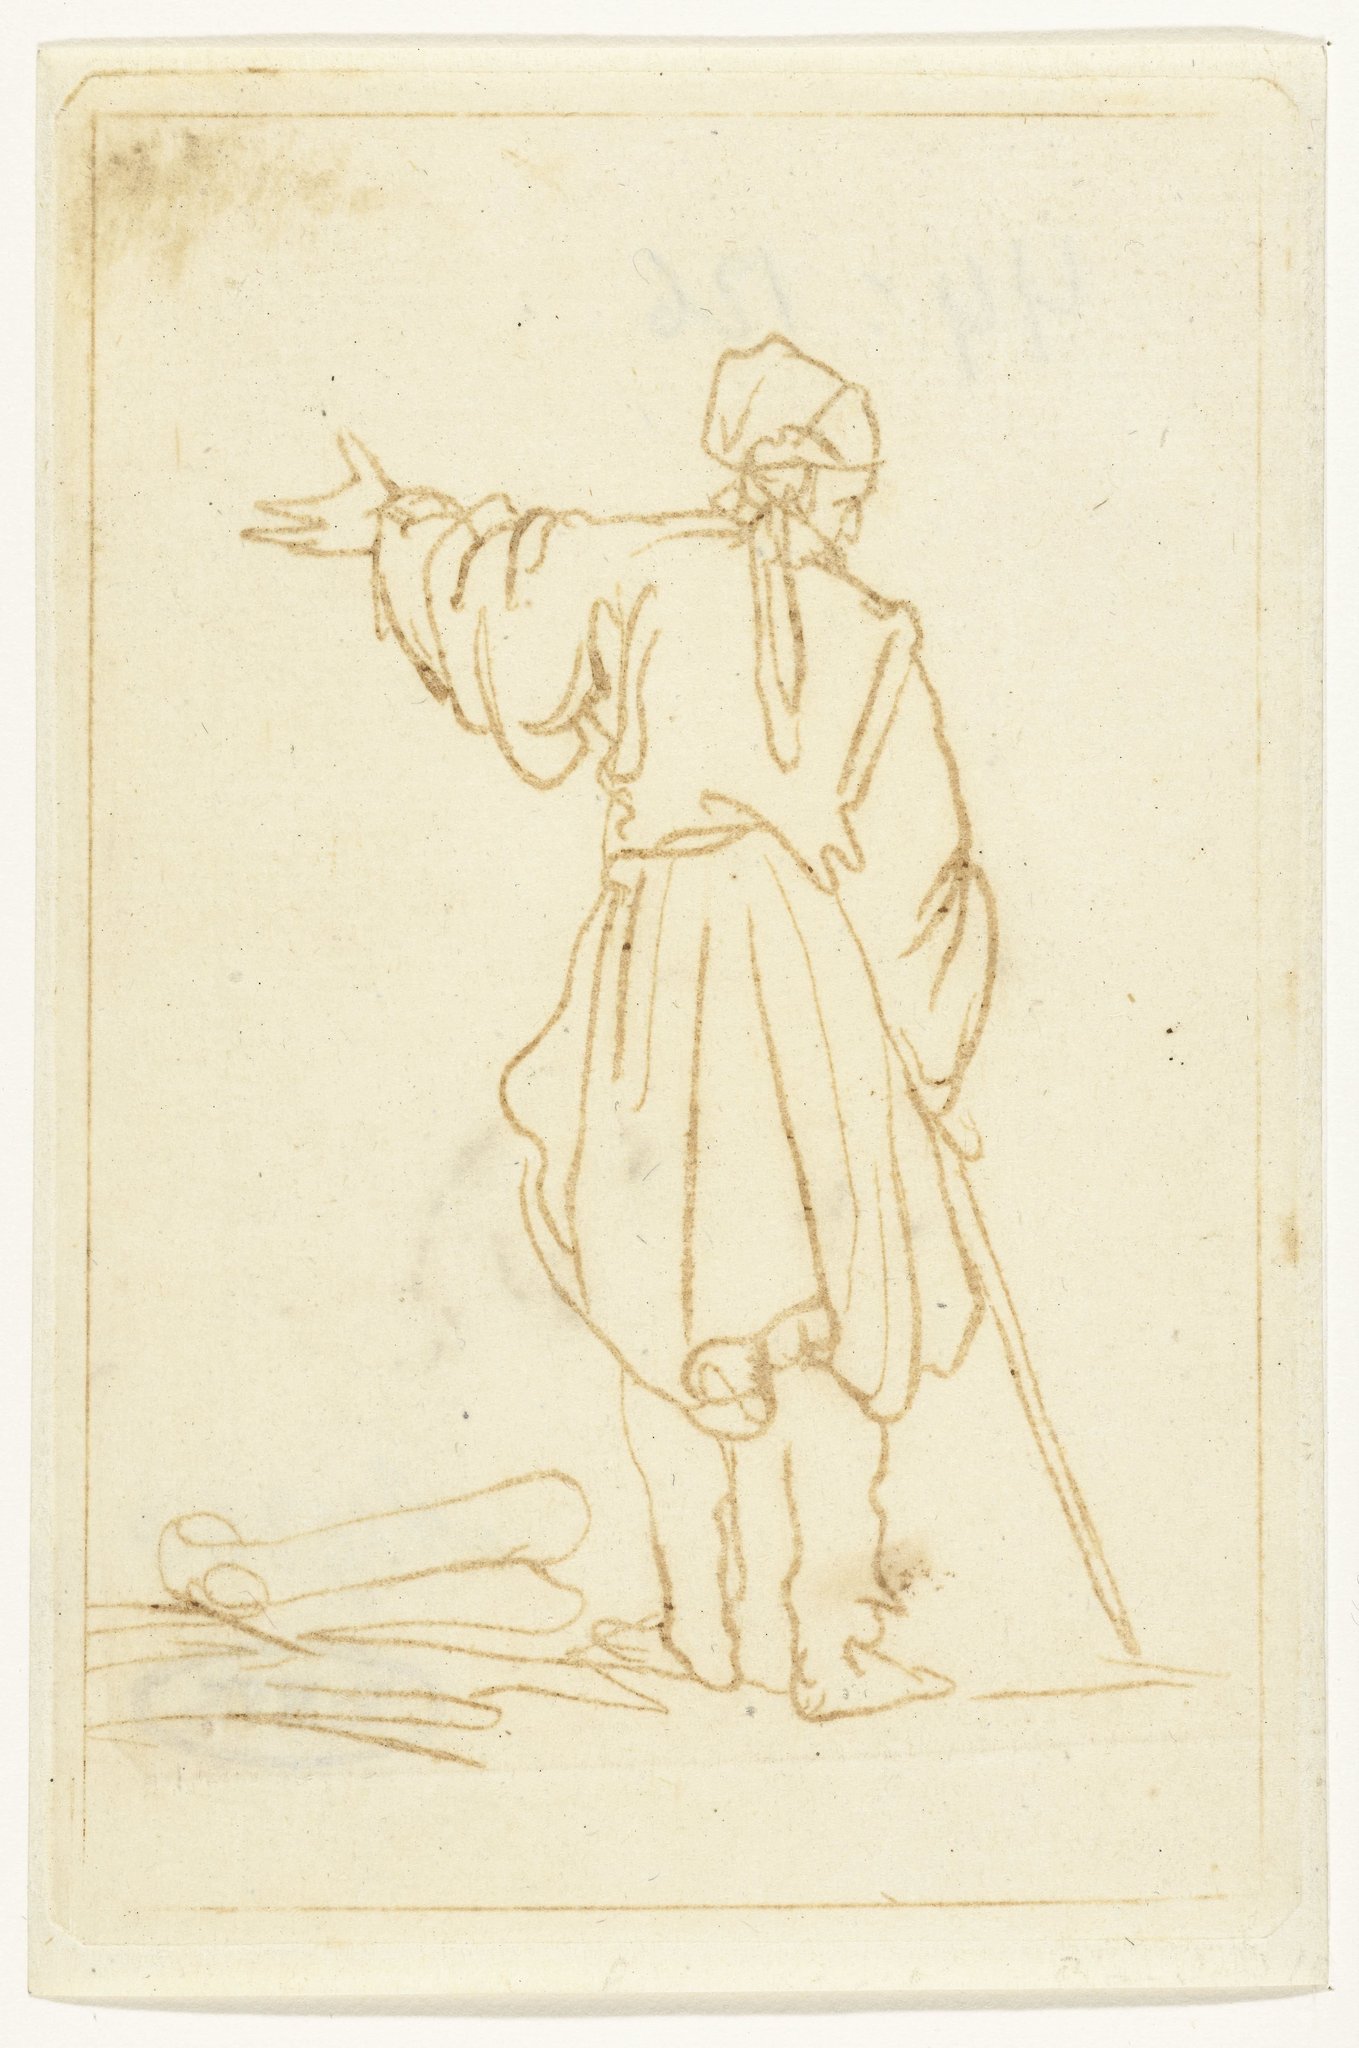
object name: print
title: Man met stok, op zijn rug gezien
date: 1798-1837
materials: paper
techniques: etching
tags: adult man (+ back view)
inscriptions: collector's mark: Lugt 2228